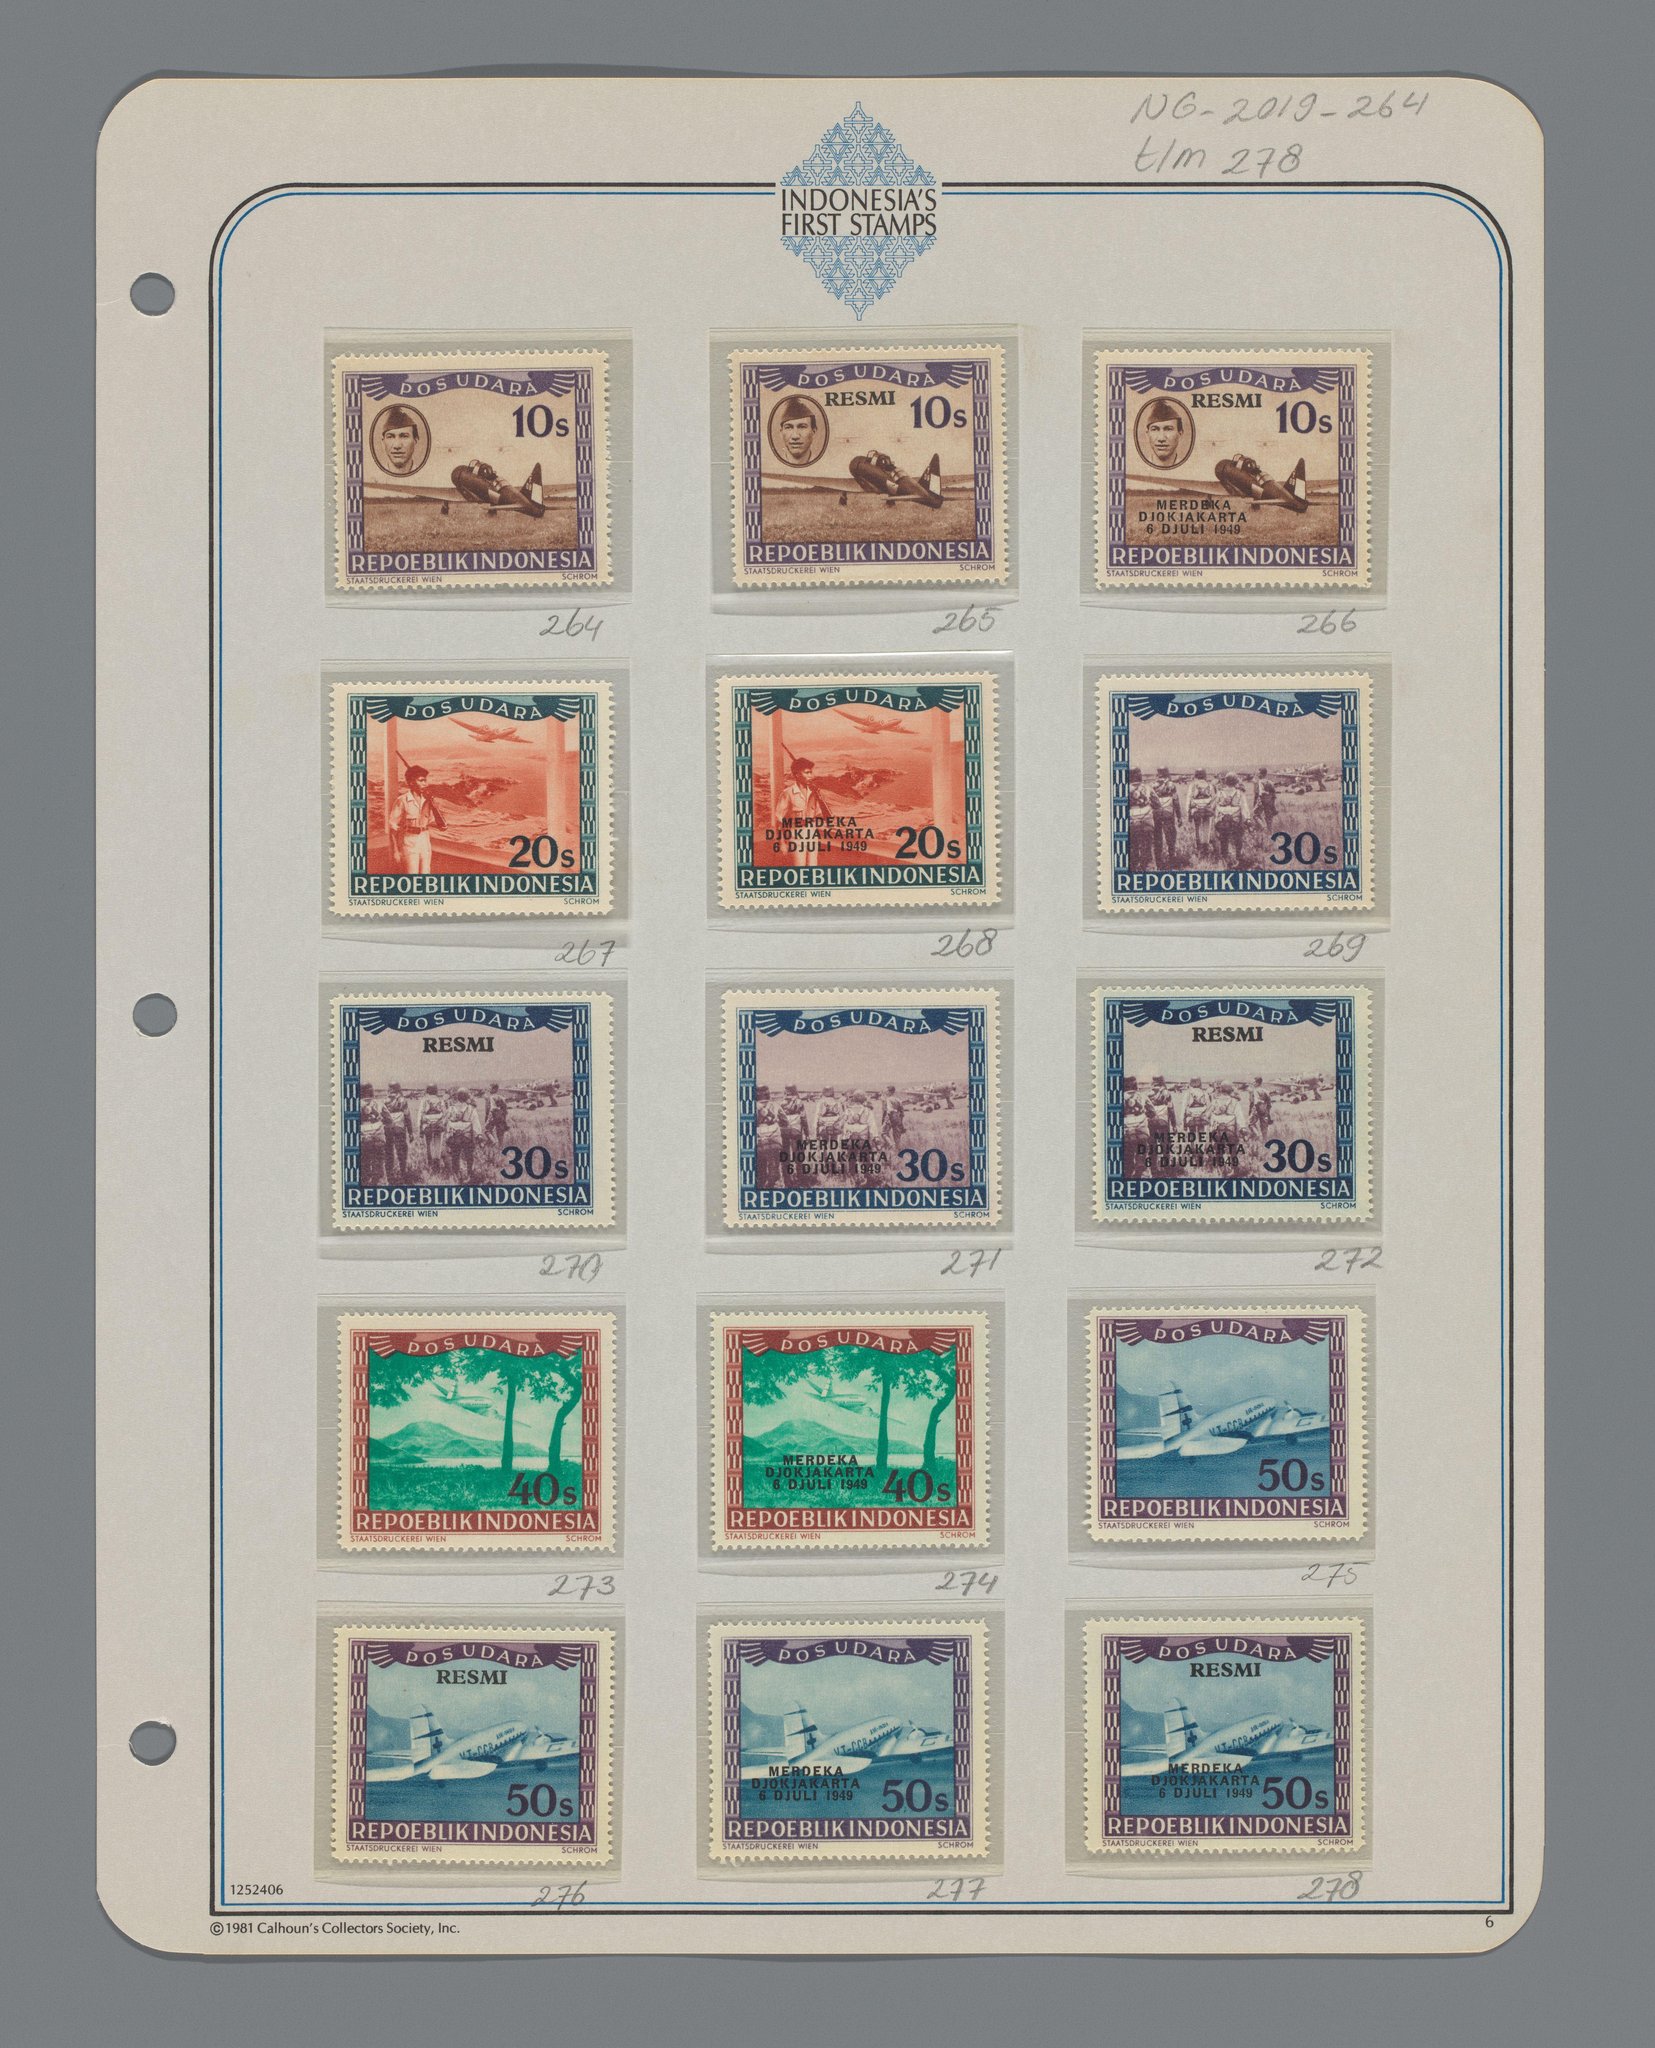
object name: postage stamp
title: Postzegel Republik Indonesia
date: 1949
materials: paper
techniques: photoaquatint, engraving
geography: philadelphia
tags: indonesia